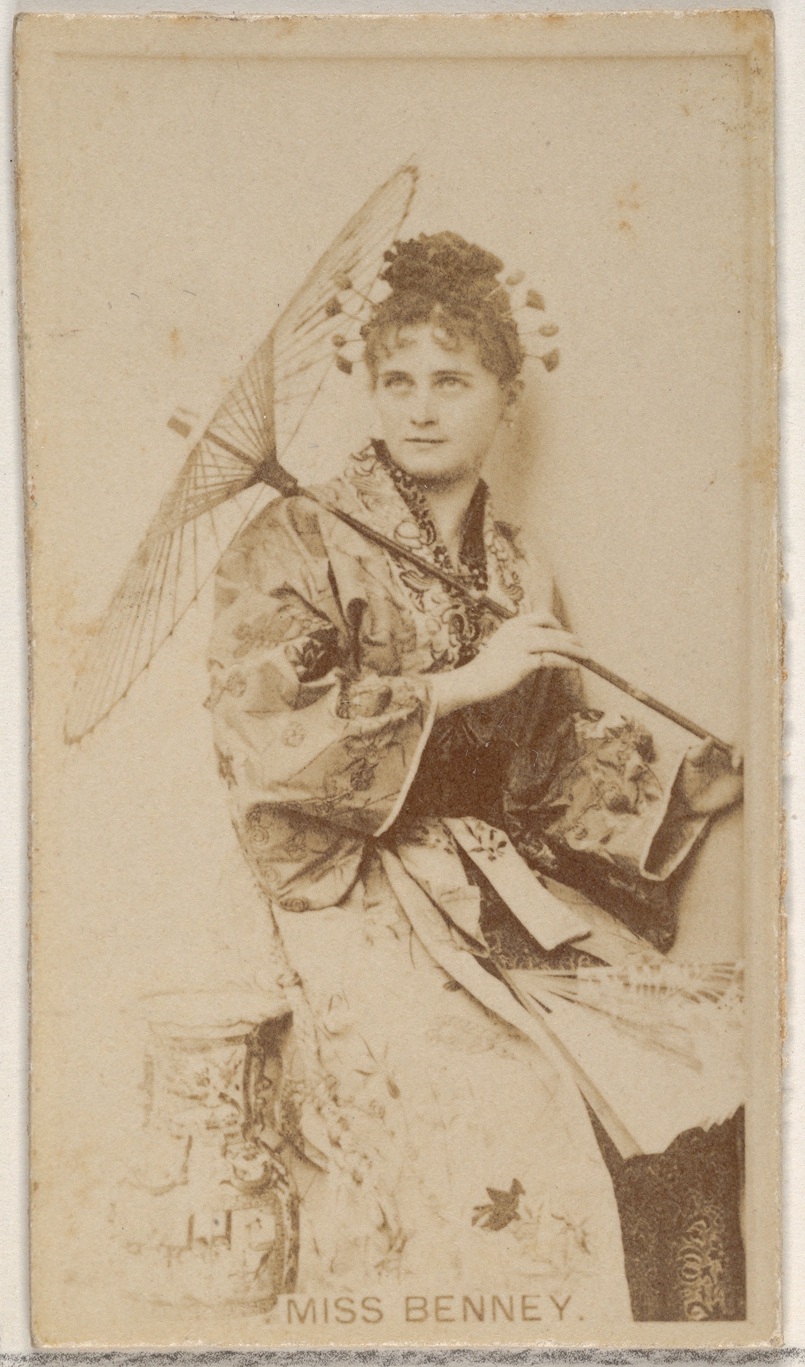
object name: photograph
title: Miss Benney, from the Actors and Actresses series (N45, Type 8) for Virginia Brights Cigarettes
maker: allen & ginter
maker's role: publisher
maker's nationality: american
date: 1888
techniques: albumen silver print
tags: portraits,women,actresses